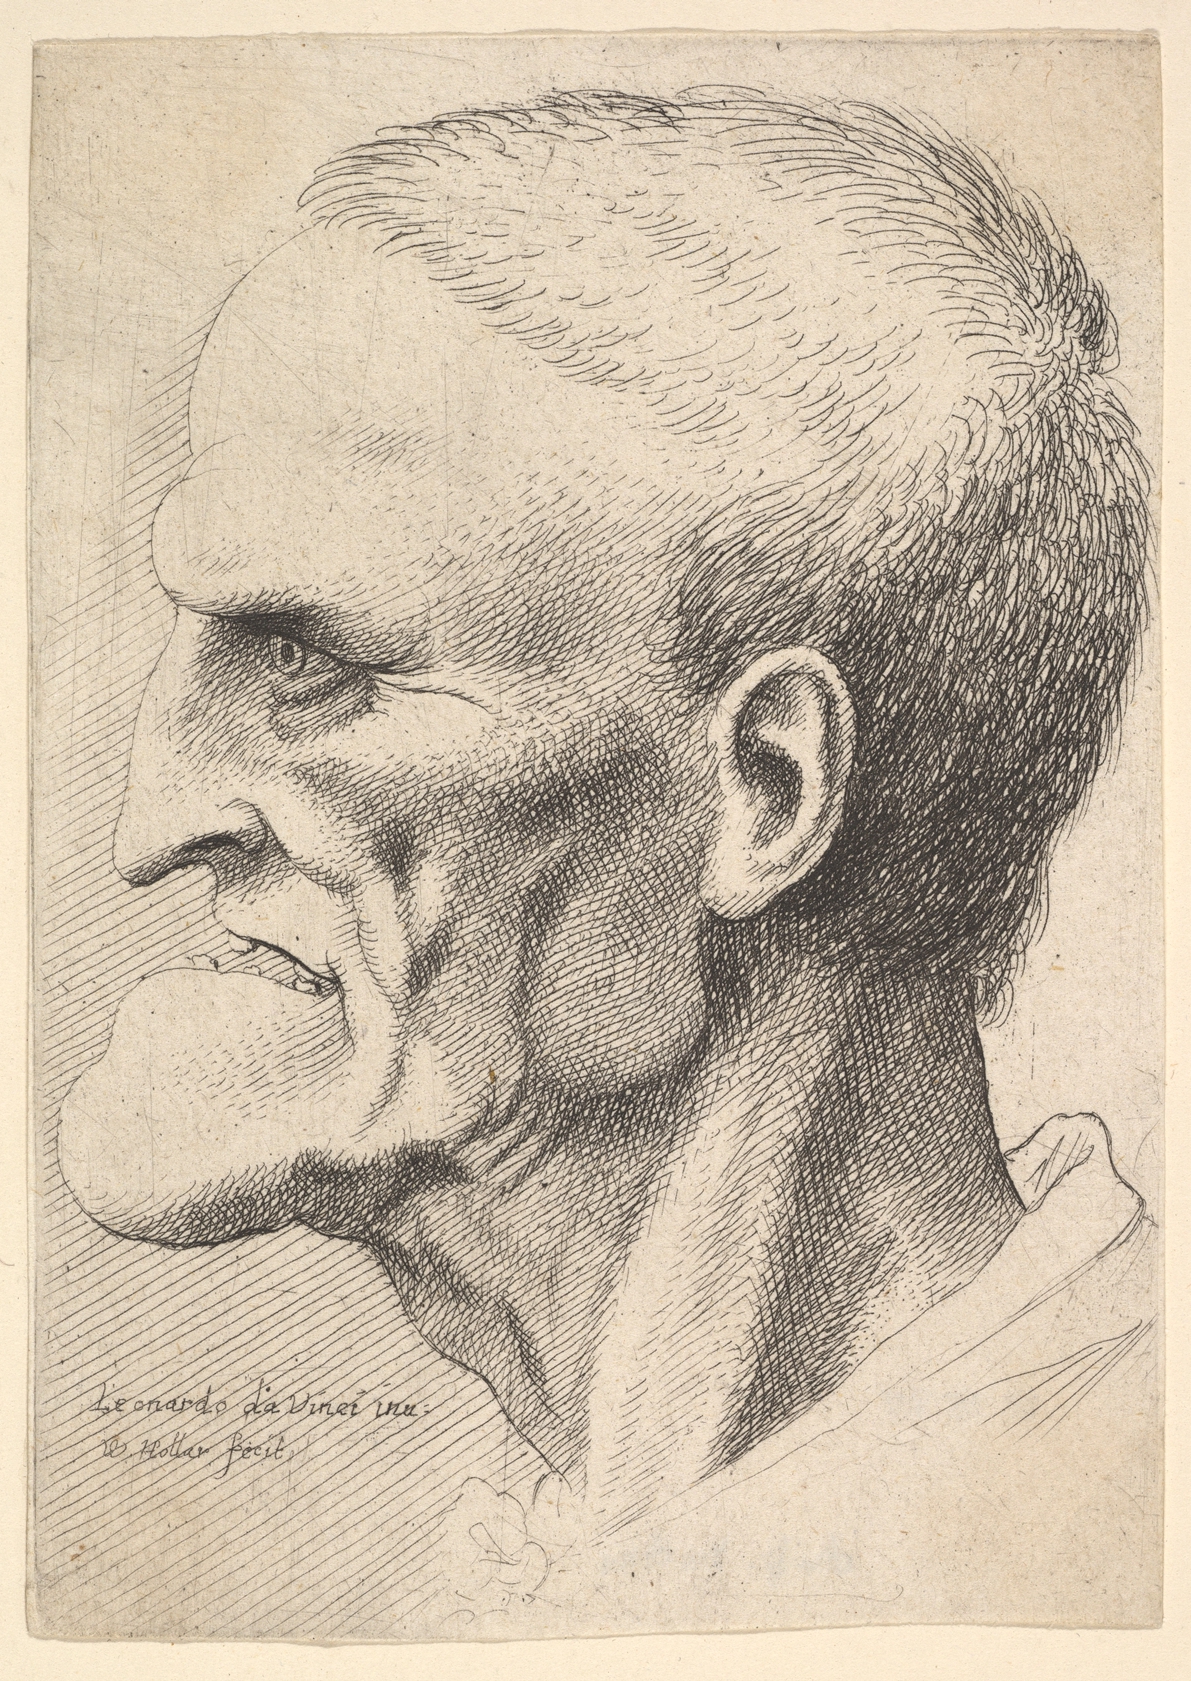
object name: print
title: Head of an old man with a pronounced chin, short cropped hair and gaping mouth showing teeth in profile to left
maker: wenceslaus hollar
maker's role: artist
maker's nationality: bohemian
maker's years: 1607-1677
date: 1644-1652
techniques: etching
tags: heads,men